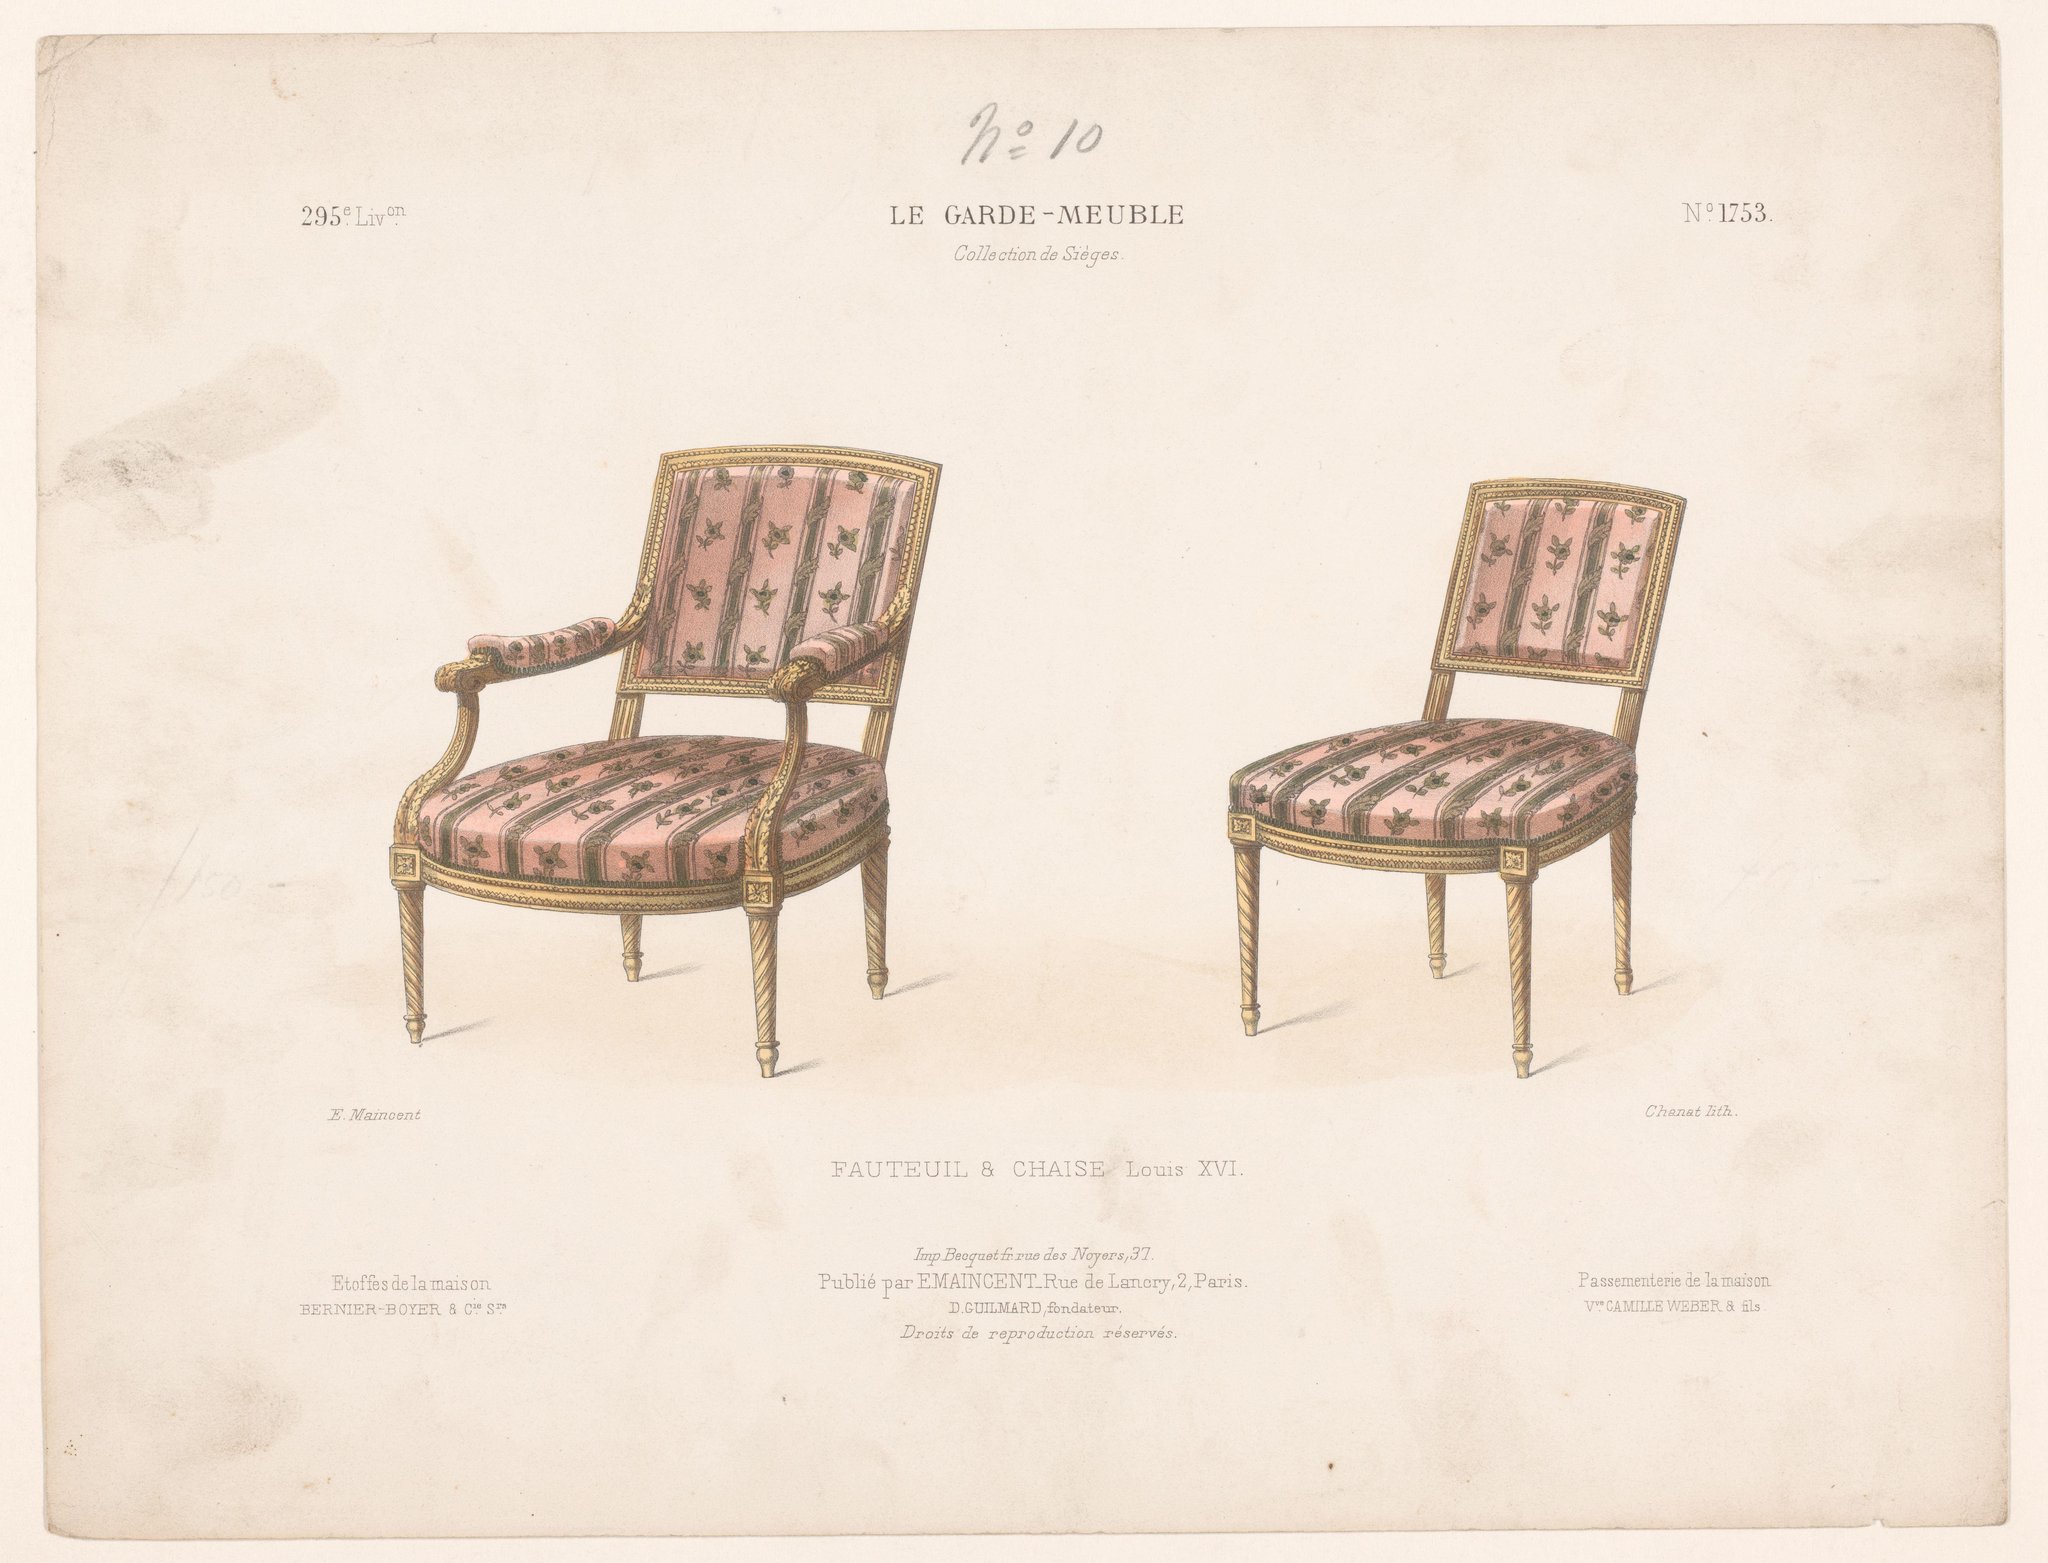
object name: print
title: Fauteuil & chaise Louis XVI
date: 1885-1895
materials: paper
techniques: hand coloring, lithograph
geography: paris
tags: seating furniture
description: Ieder Livraison in de serie Le Garde-Meuble bevat negen platen: drie 'sièges' (zitmeubels), drie 'meubles' (diverse meubels zoals tafels en kasten) en drie 'tentures' (gordijnen en draperieën).